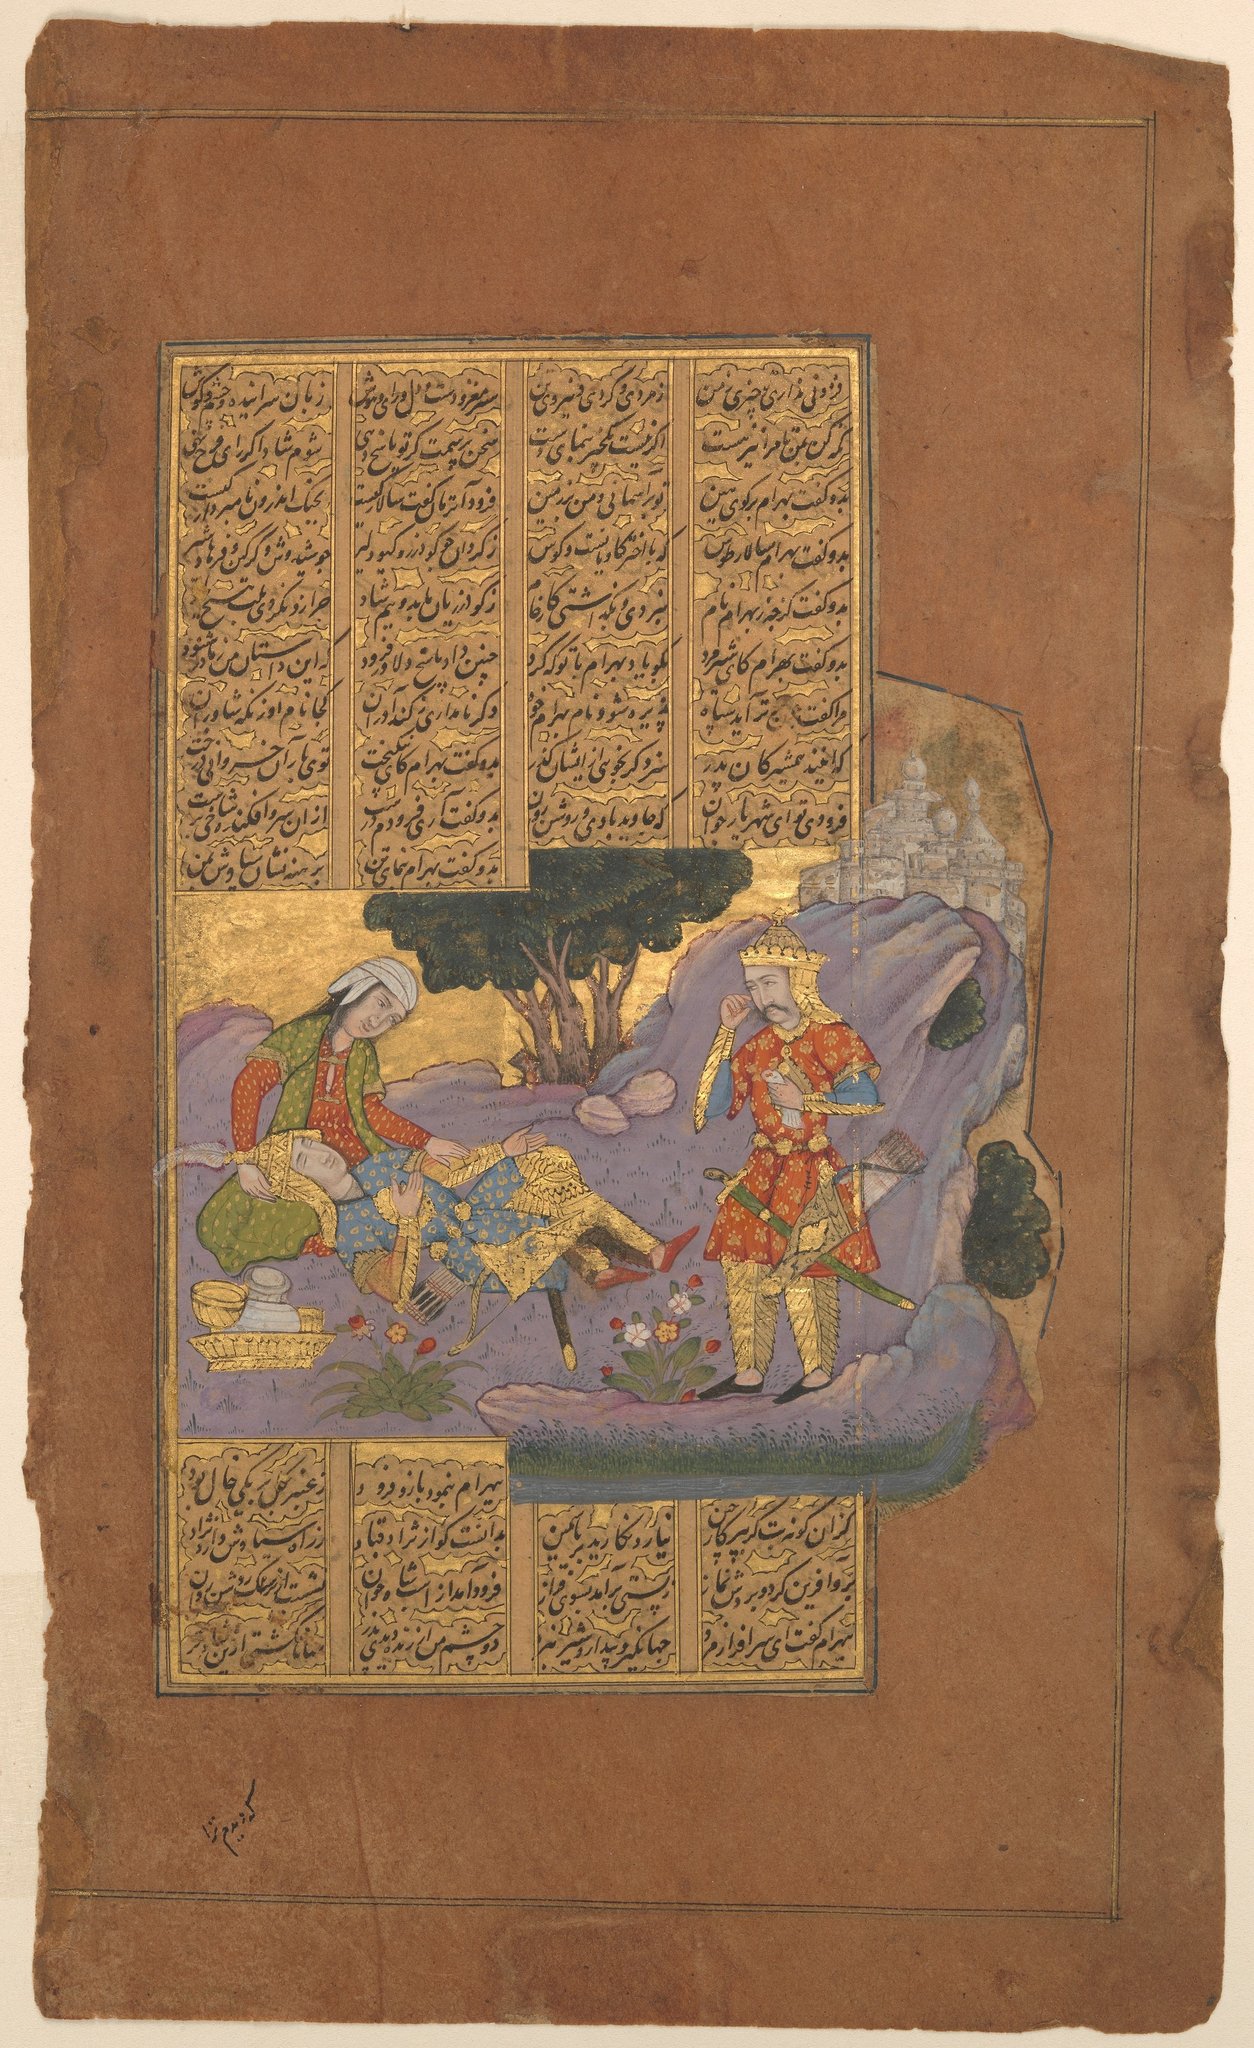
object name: folio from an illustrated manuscript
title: "Death of Farud", Folio from a Shahnama (Book of Kings) of Firdausi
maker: abu'l qasim firdausi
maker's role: author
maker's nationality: iranian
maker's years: 935-1020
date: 1610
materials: gold, ink, paper, watercolor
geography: india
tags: poetry,men,death